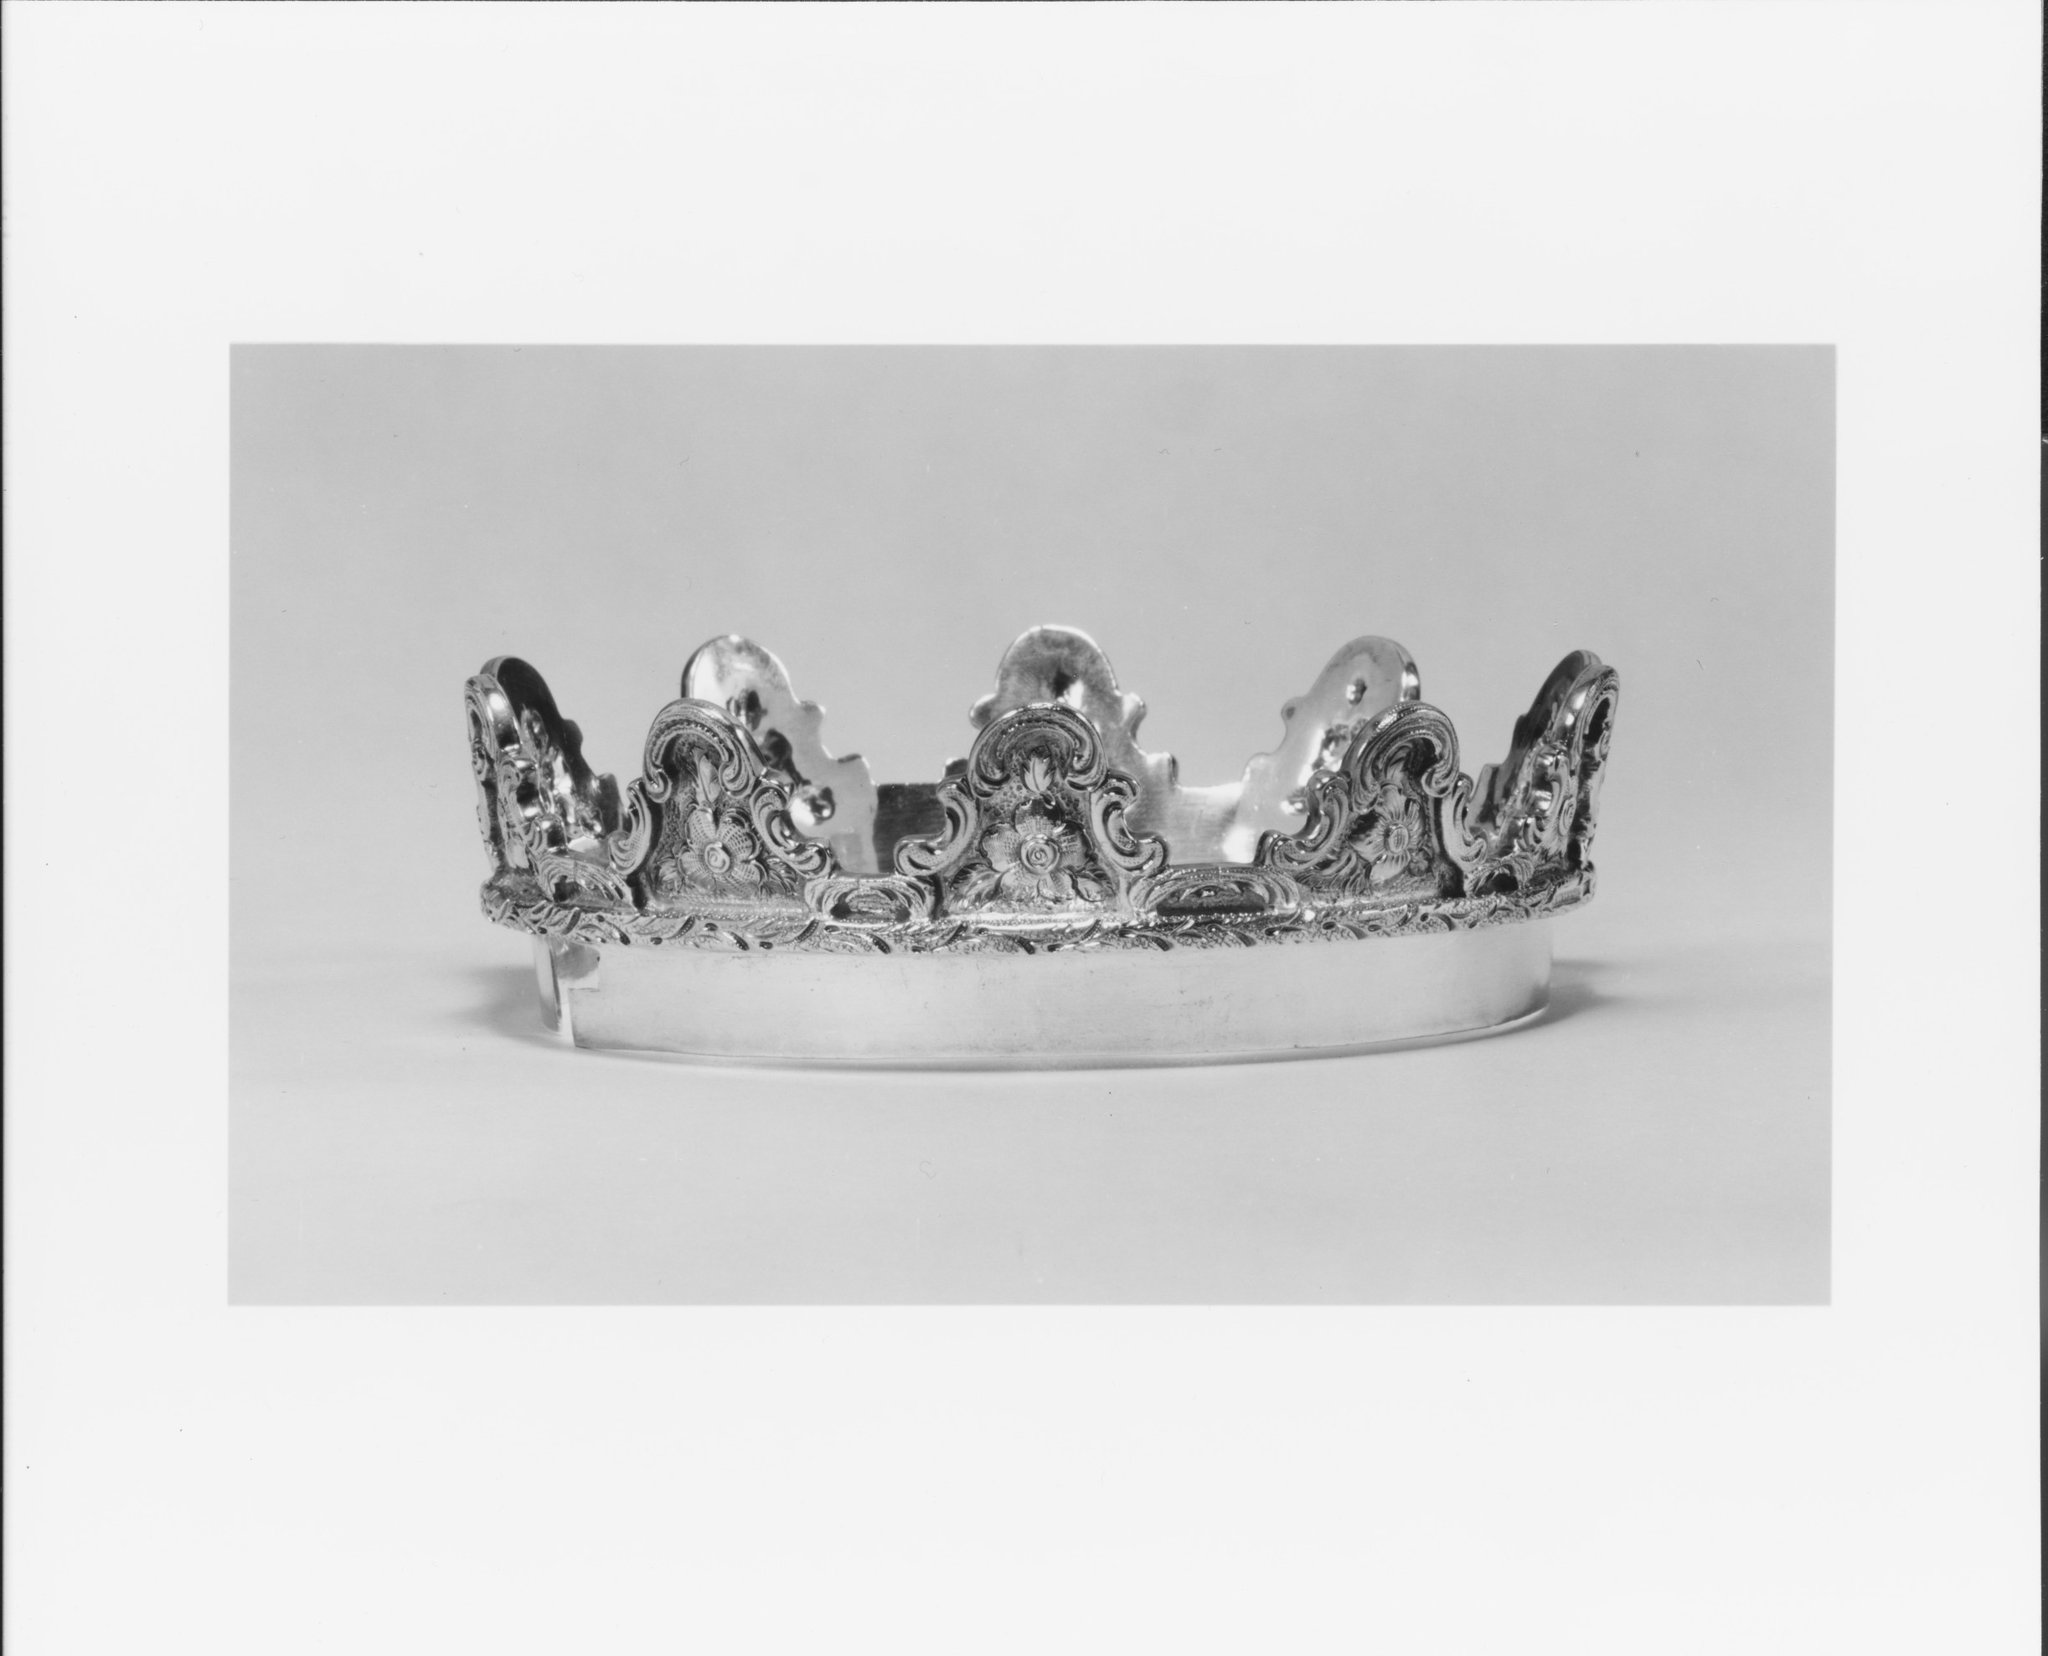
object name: waste bowl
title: Rim for Waste Bowl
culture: american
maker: andrew ellicott warner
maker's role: maker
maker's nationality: american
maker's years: 1786-1870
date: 1845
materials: silver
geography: united states